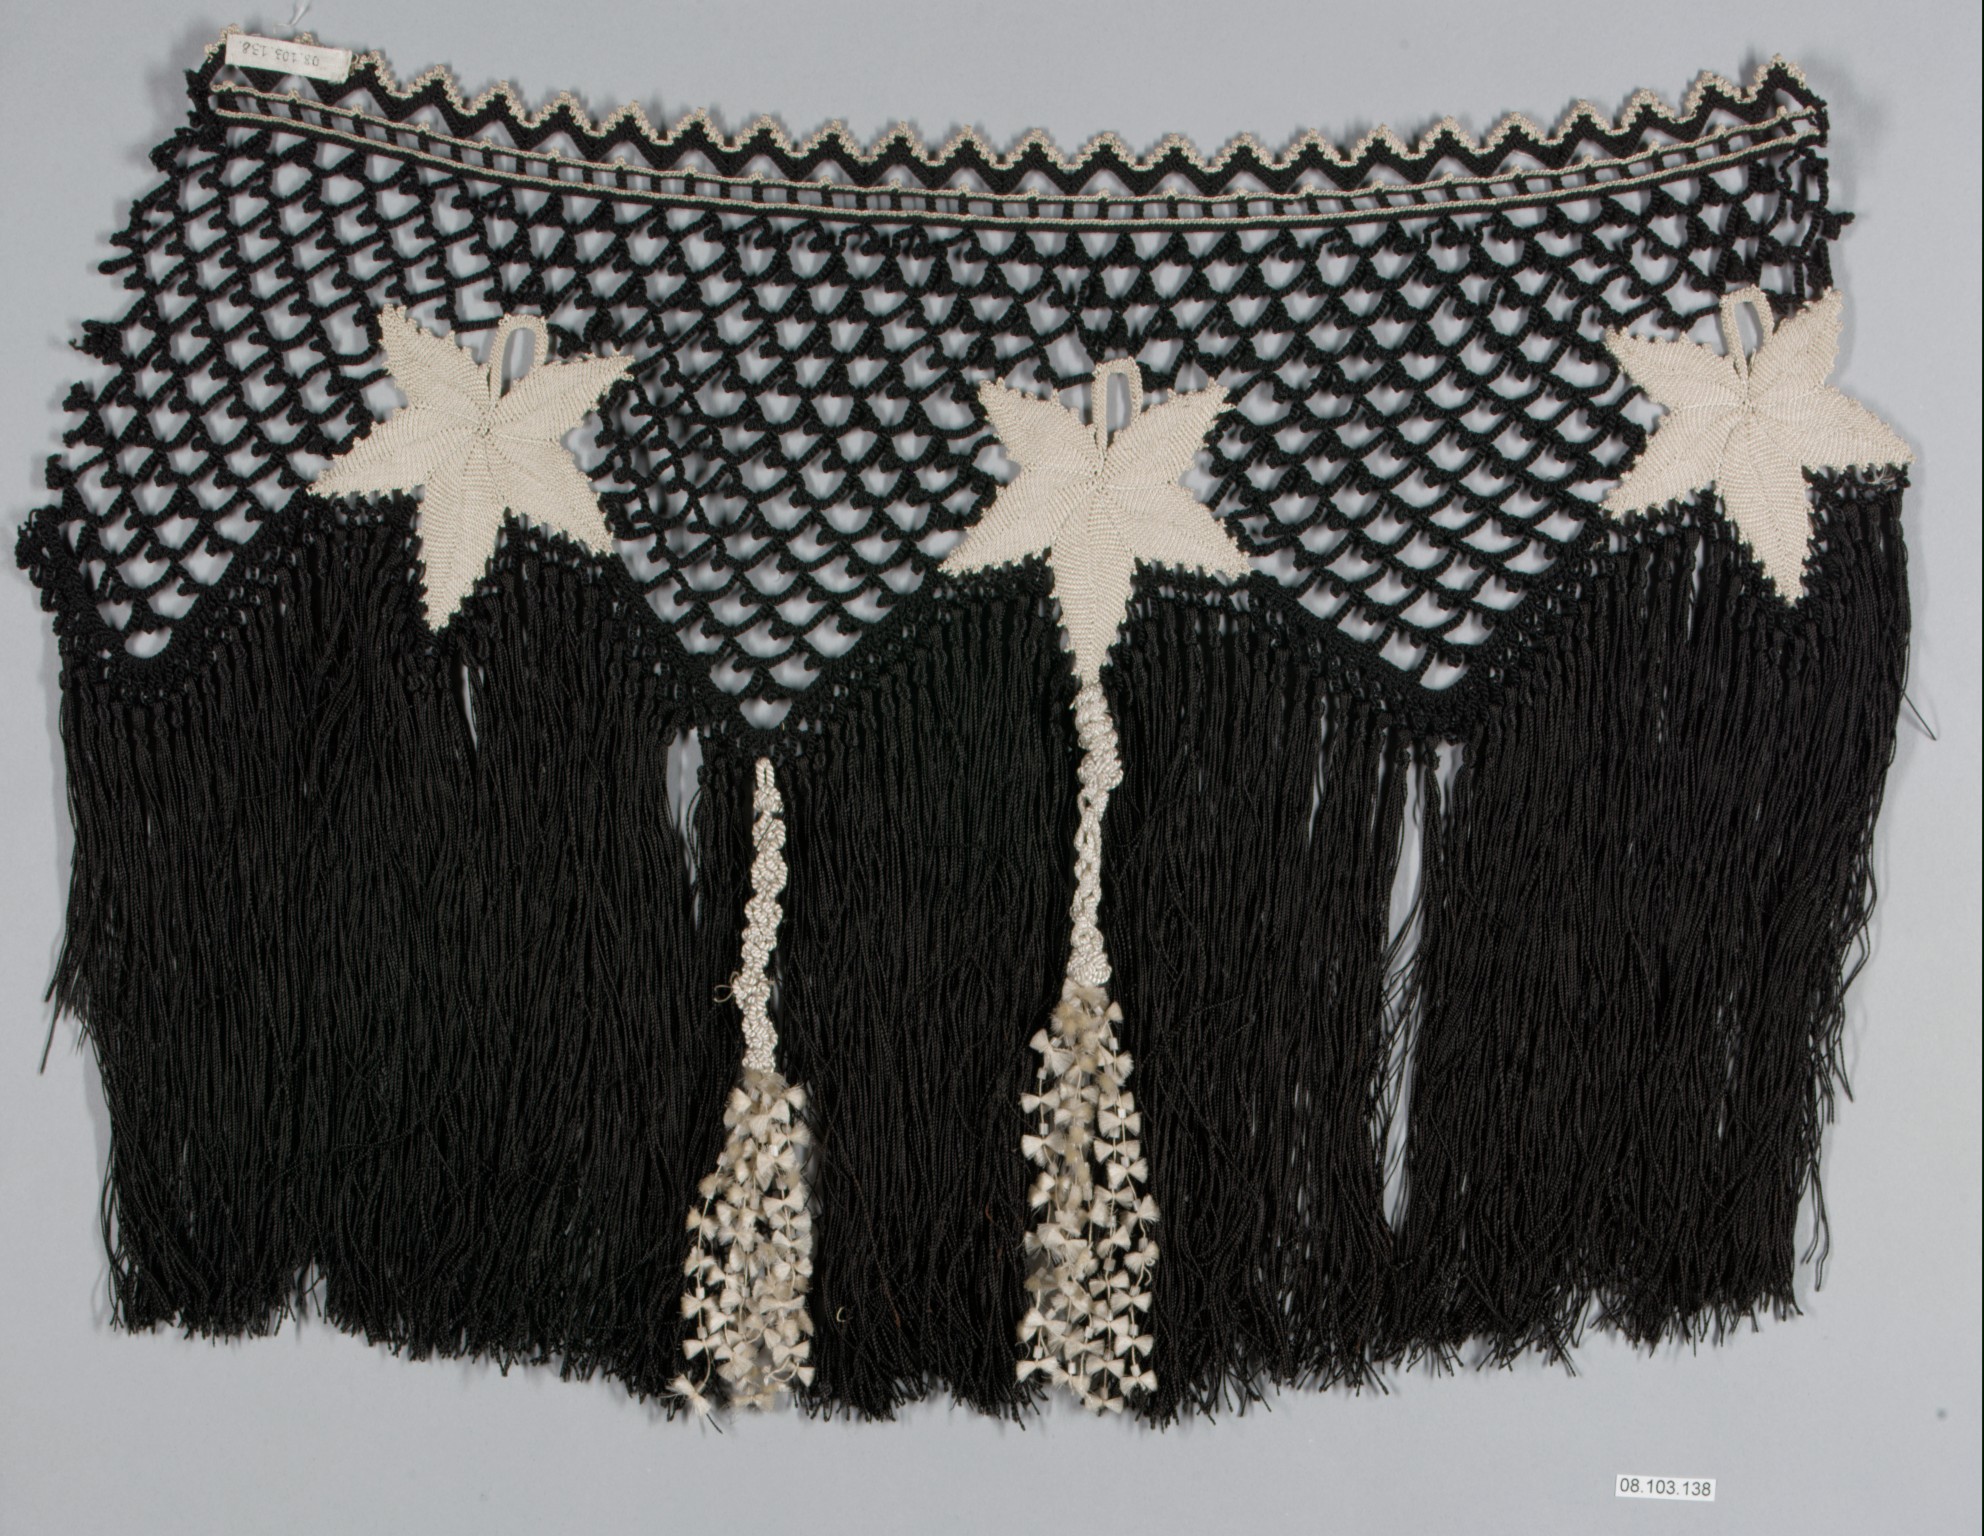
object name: fringe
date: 1880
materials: silk